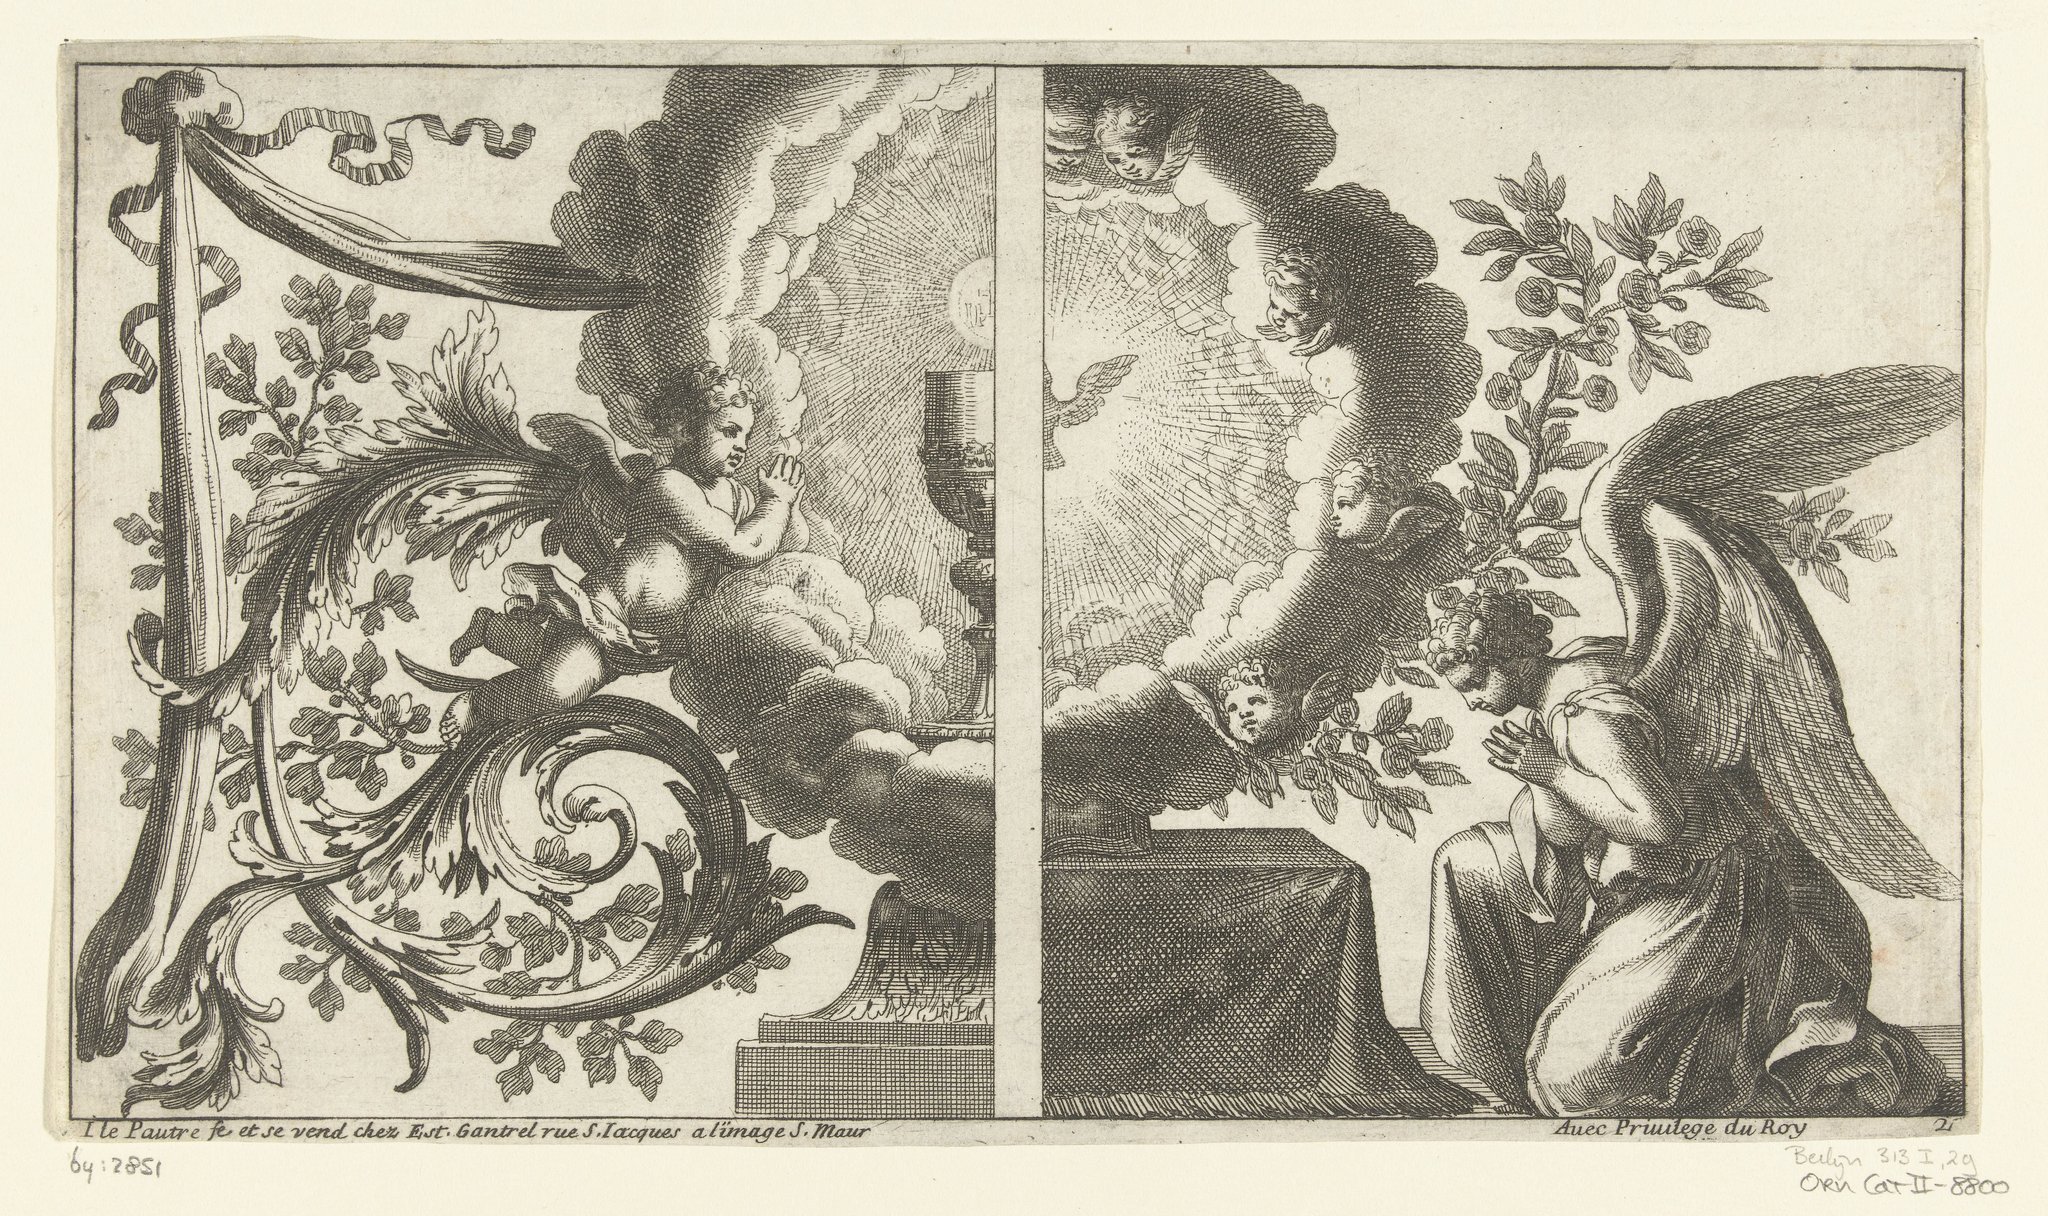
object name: print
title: Liure de Panaux pour les Lambris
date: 1656-1706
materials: paper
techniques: etching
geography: france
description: De cherubijn bidt tot een monstrans en de engel bidt tot de Heilige Geest.